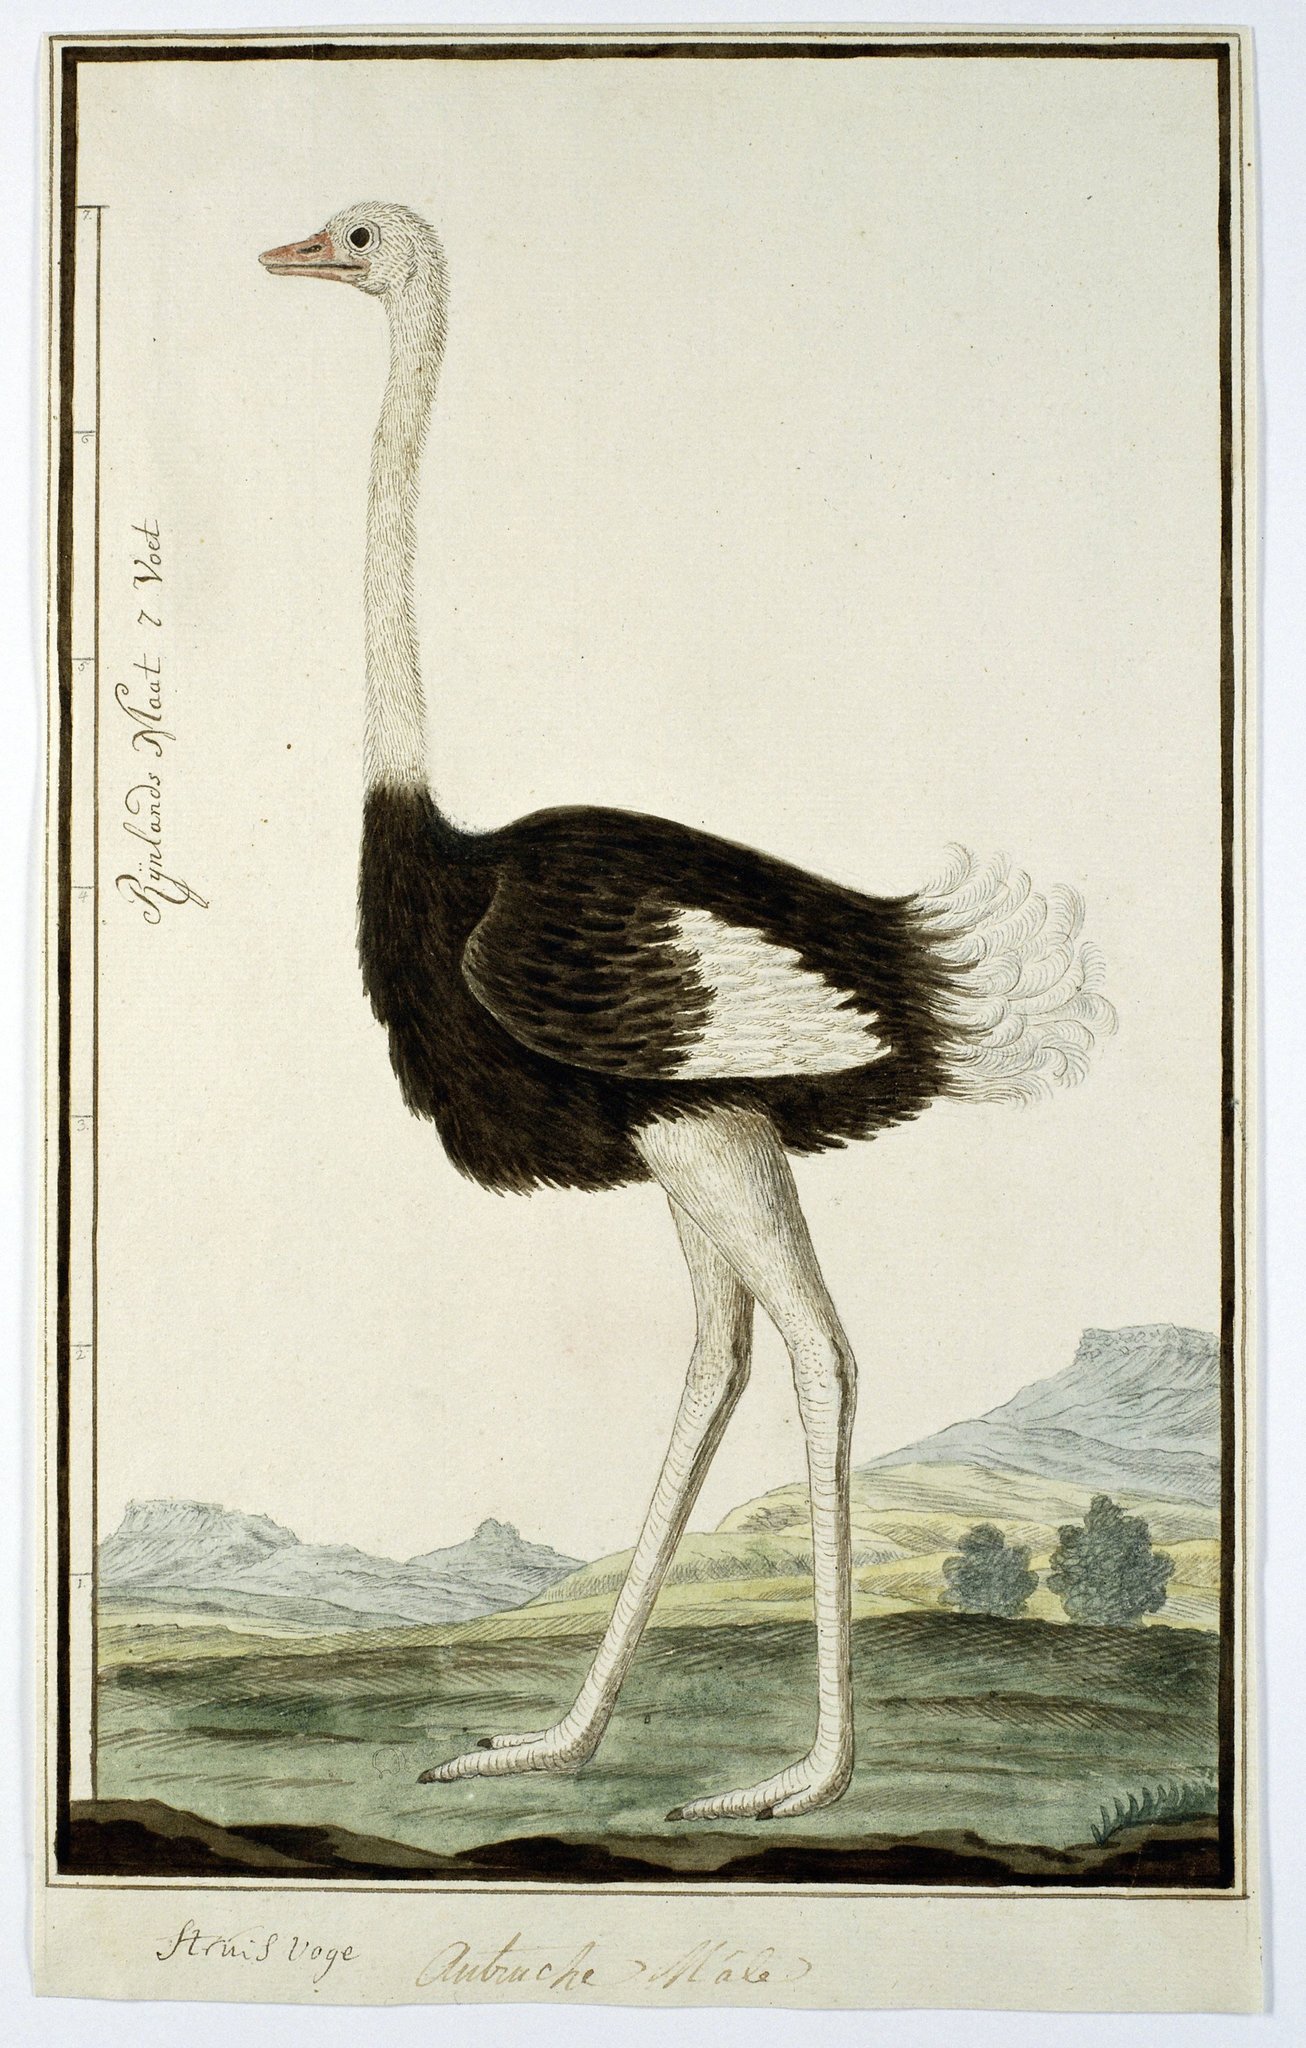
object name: drawing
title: Struthio camelus (Common Ostrich)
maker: robert jacob gordon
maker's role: draughtsman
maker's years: 1743-1795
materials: chalk, ink, paper, pencil, watercolor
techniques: brush, pen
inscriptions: annotation: ‘Struisvoge ; Autruche Mâle; linkerkant schaalverdeling met: Rijnlandse Maat en Voet’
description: Ook in Rijksmuseum Kunstkrant, jrg. 28 (mei-jun.2002), nr. 3, p. 14, kleurafb. Franse benaming geschreven door Levaillant.